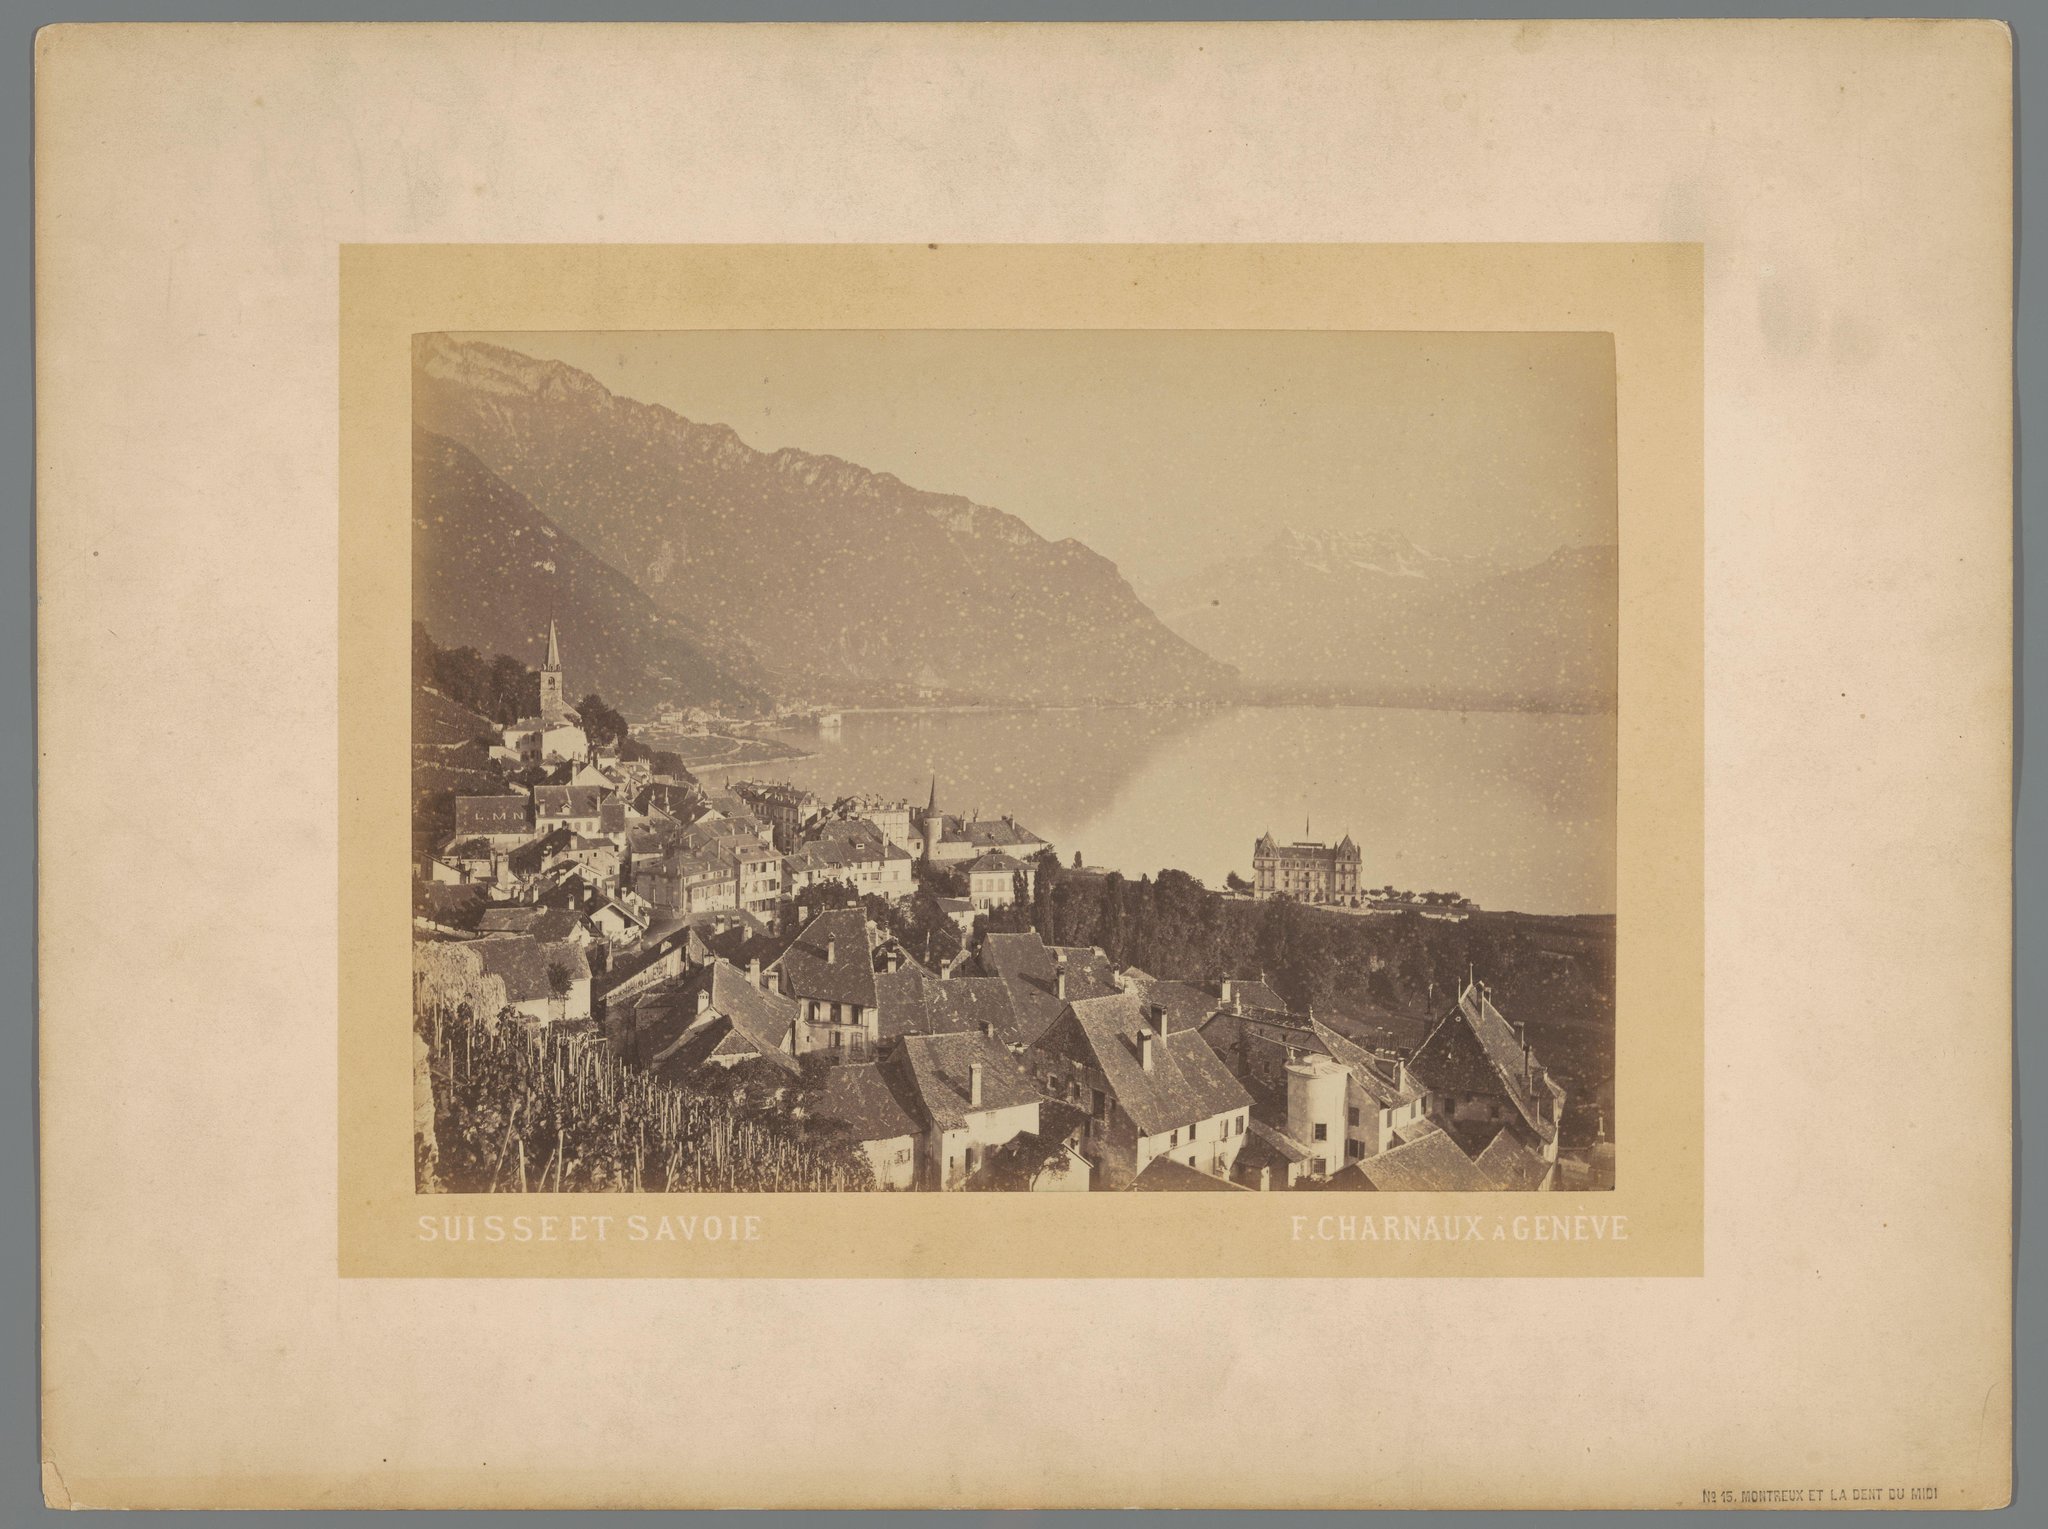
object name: photograph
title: Suisse et Savoie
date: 1870-1890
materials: cardboard, paper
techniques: albumen print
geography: geneva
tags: city-view in general; 'veduta', lake, mountains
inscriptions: number: ‘No 15.’